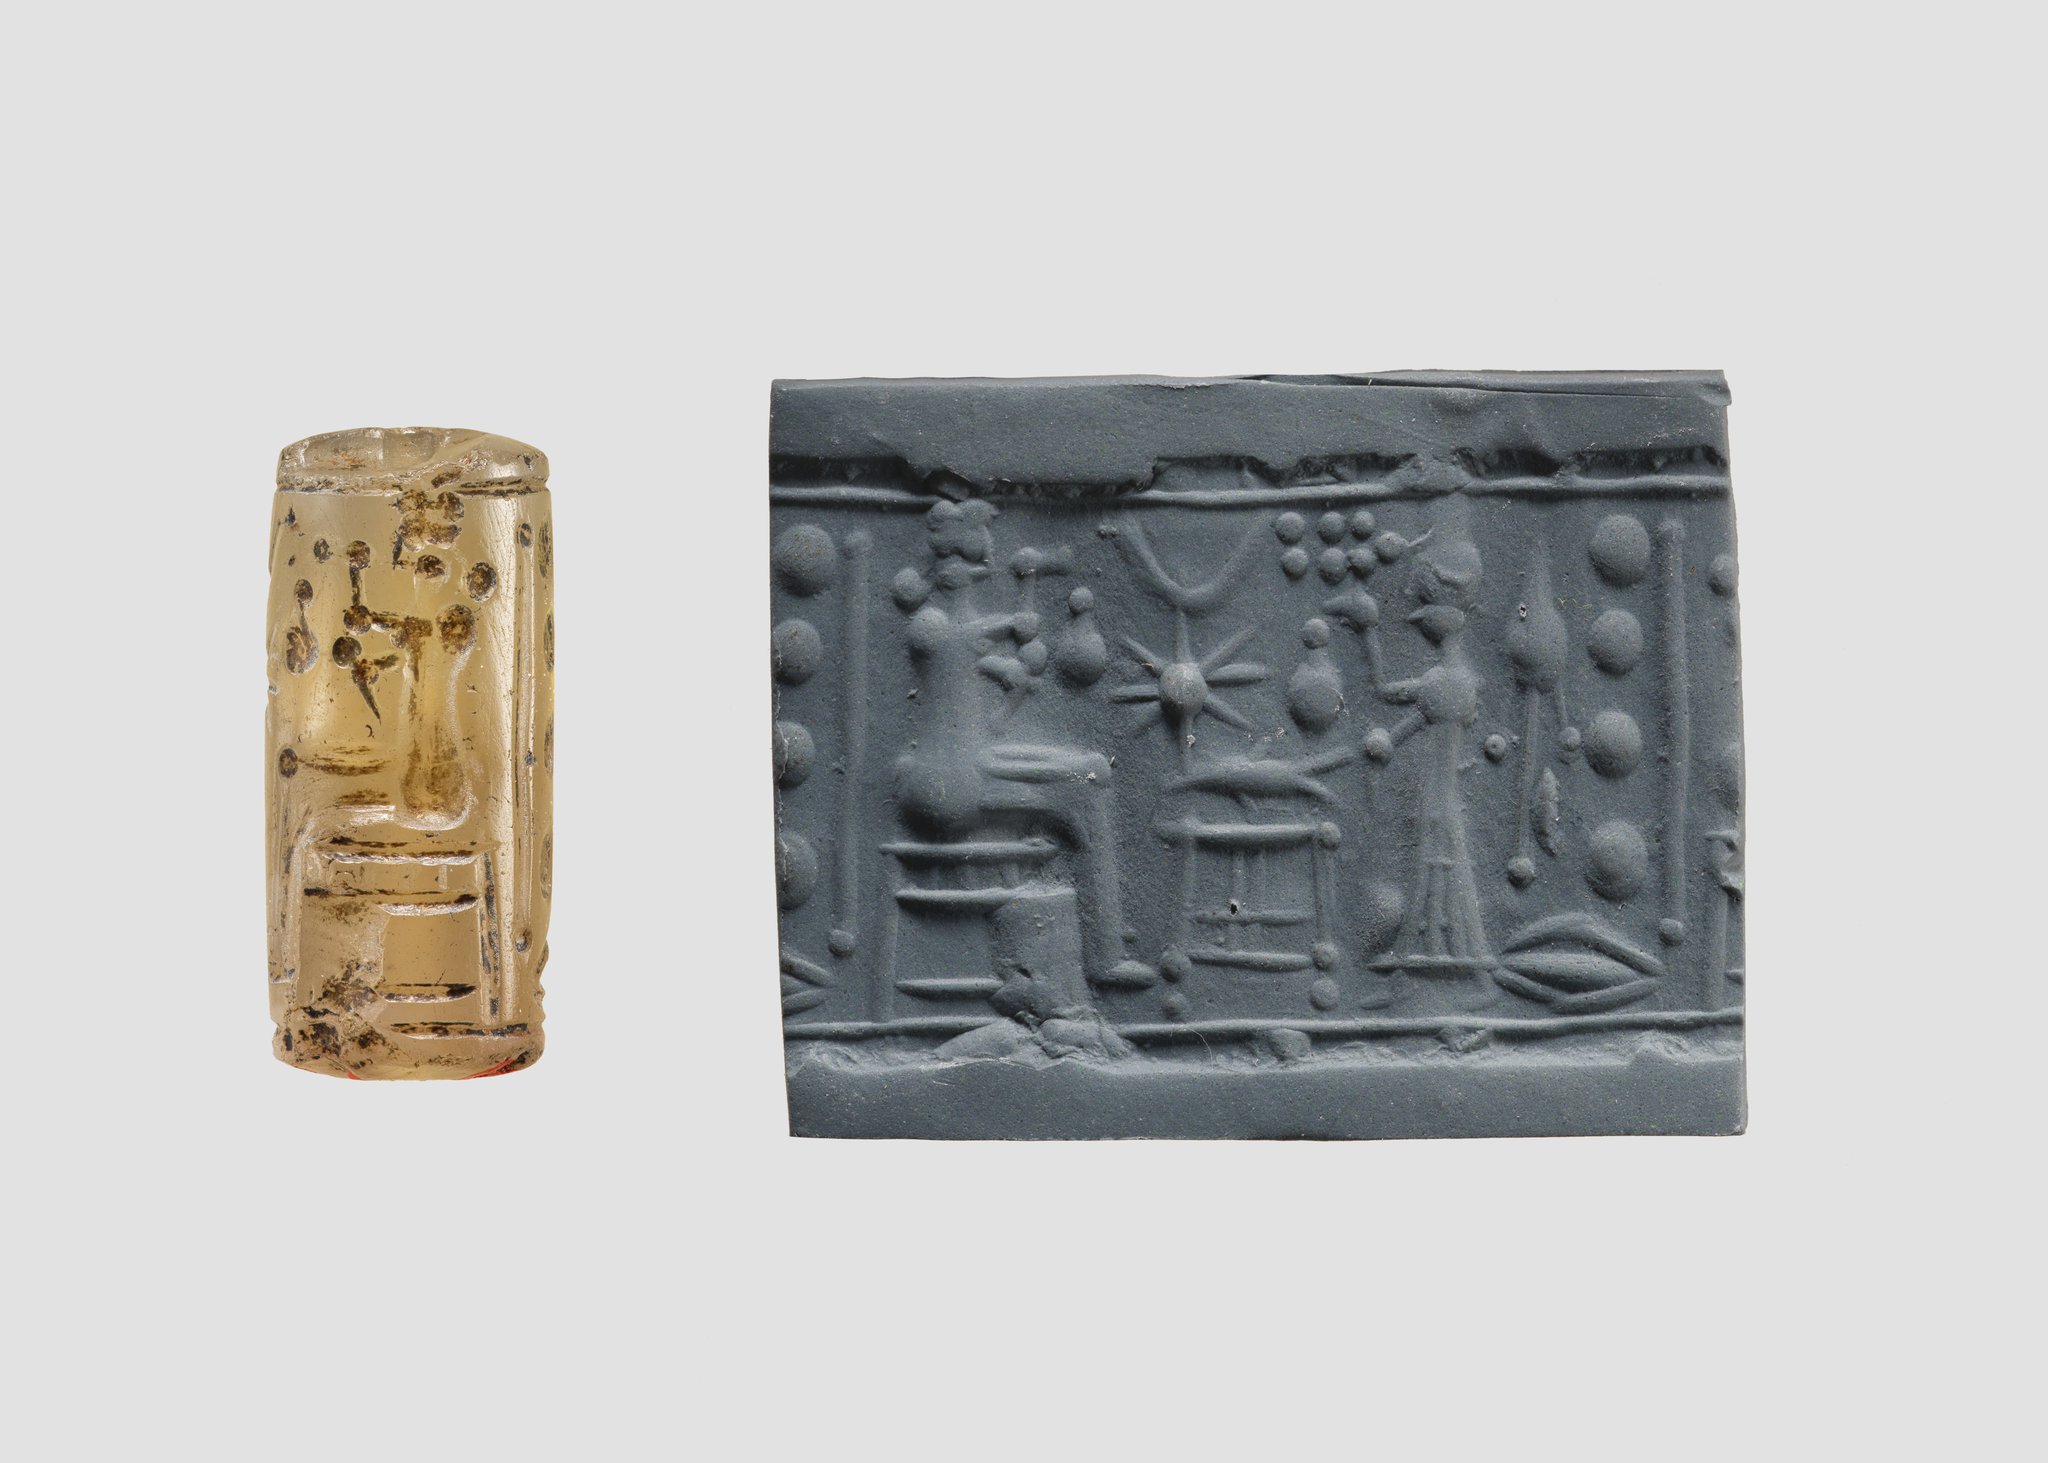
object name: cylinder seal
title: Cylinder seal with cultic banquet scene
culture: assyrian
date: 800-601 BCE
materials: stone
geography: mesopotamia